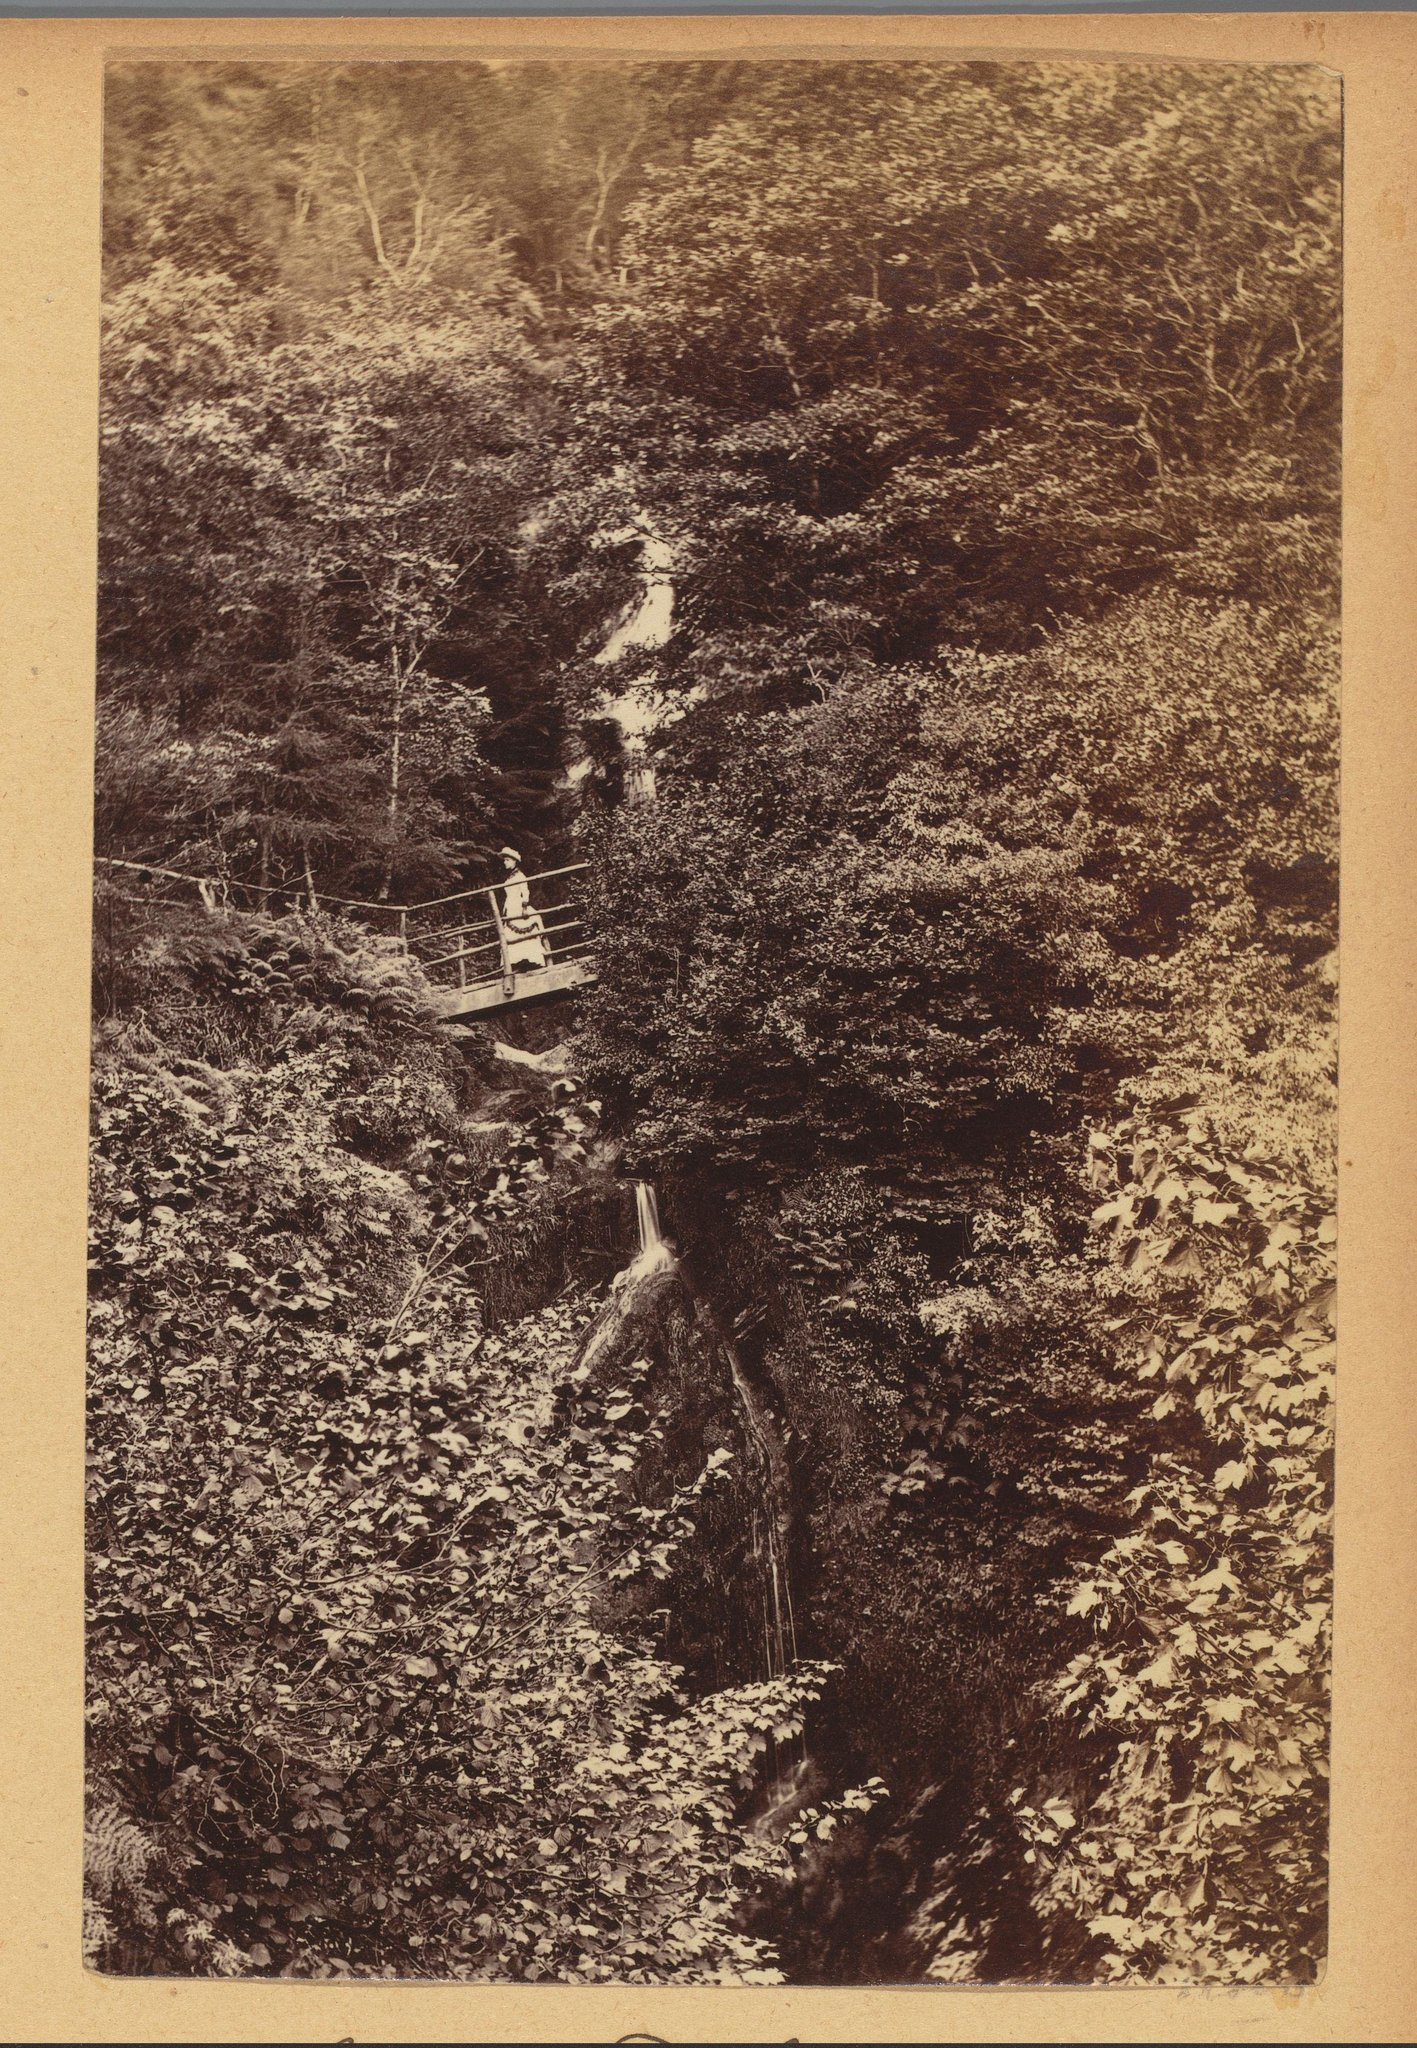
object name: album leaf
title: Waterval, Glen Dhoon, Isle of Man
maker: Anonymous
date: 1870-1890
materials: cardboard, paper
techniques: albumen print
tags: great britain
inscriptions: caption: ‘Dhoon Glen.’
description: Foto zit samen met RP-F-00-6312-1(V) en RP-F-00-6312-2(V) op één albumblad geplakt.